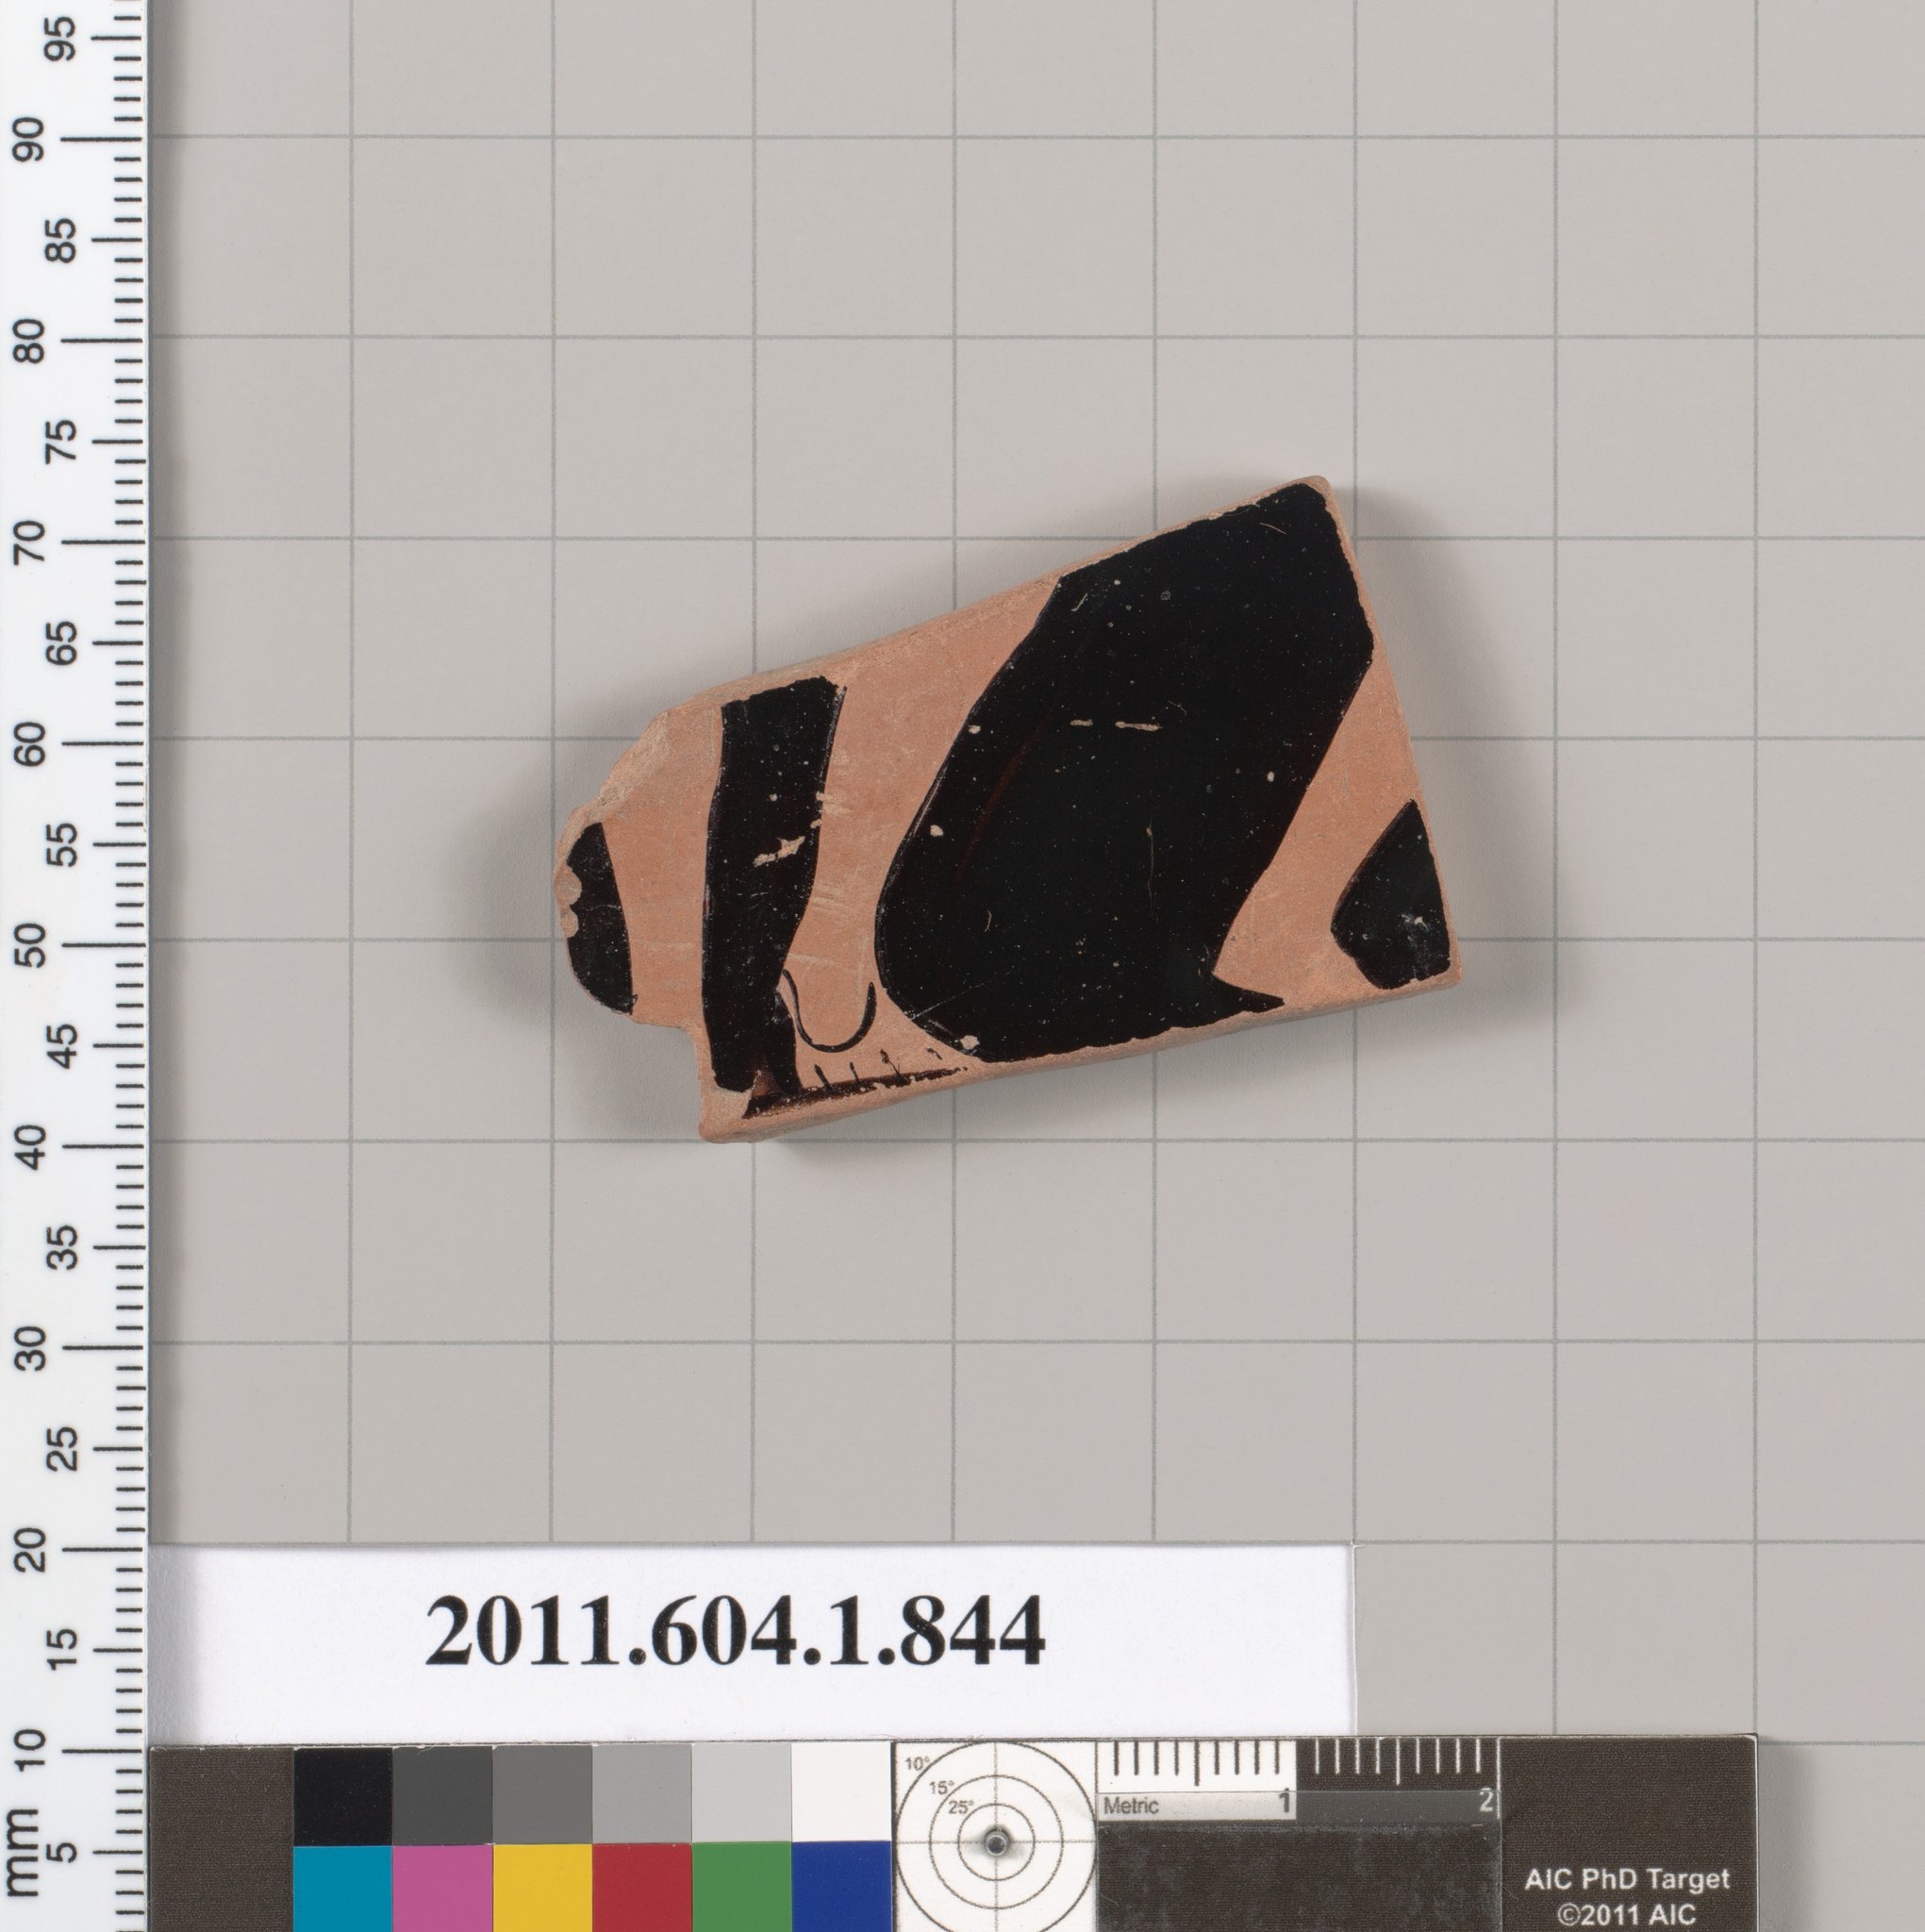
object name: kylix fragment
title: Terracotta fragment of a kylix (drinking cup)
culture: greek, attic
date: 475-451 BCE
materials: terracotta